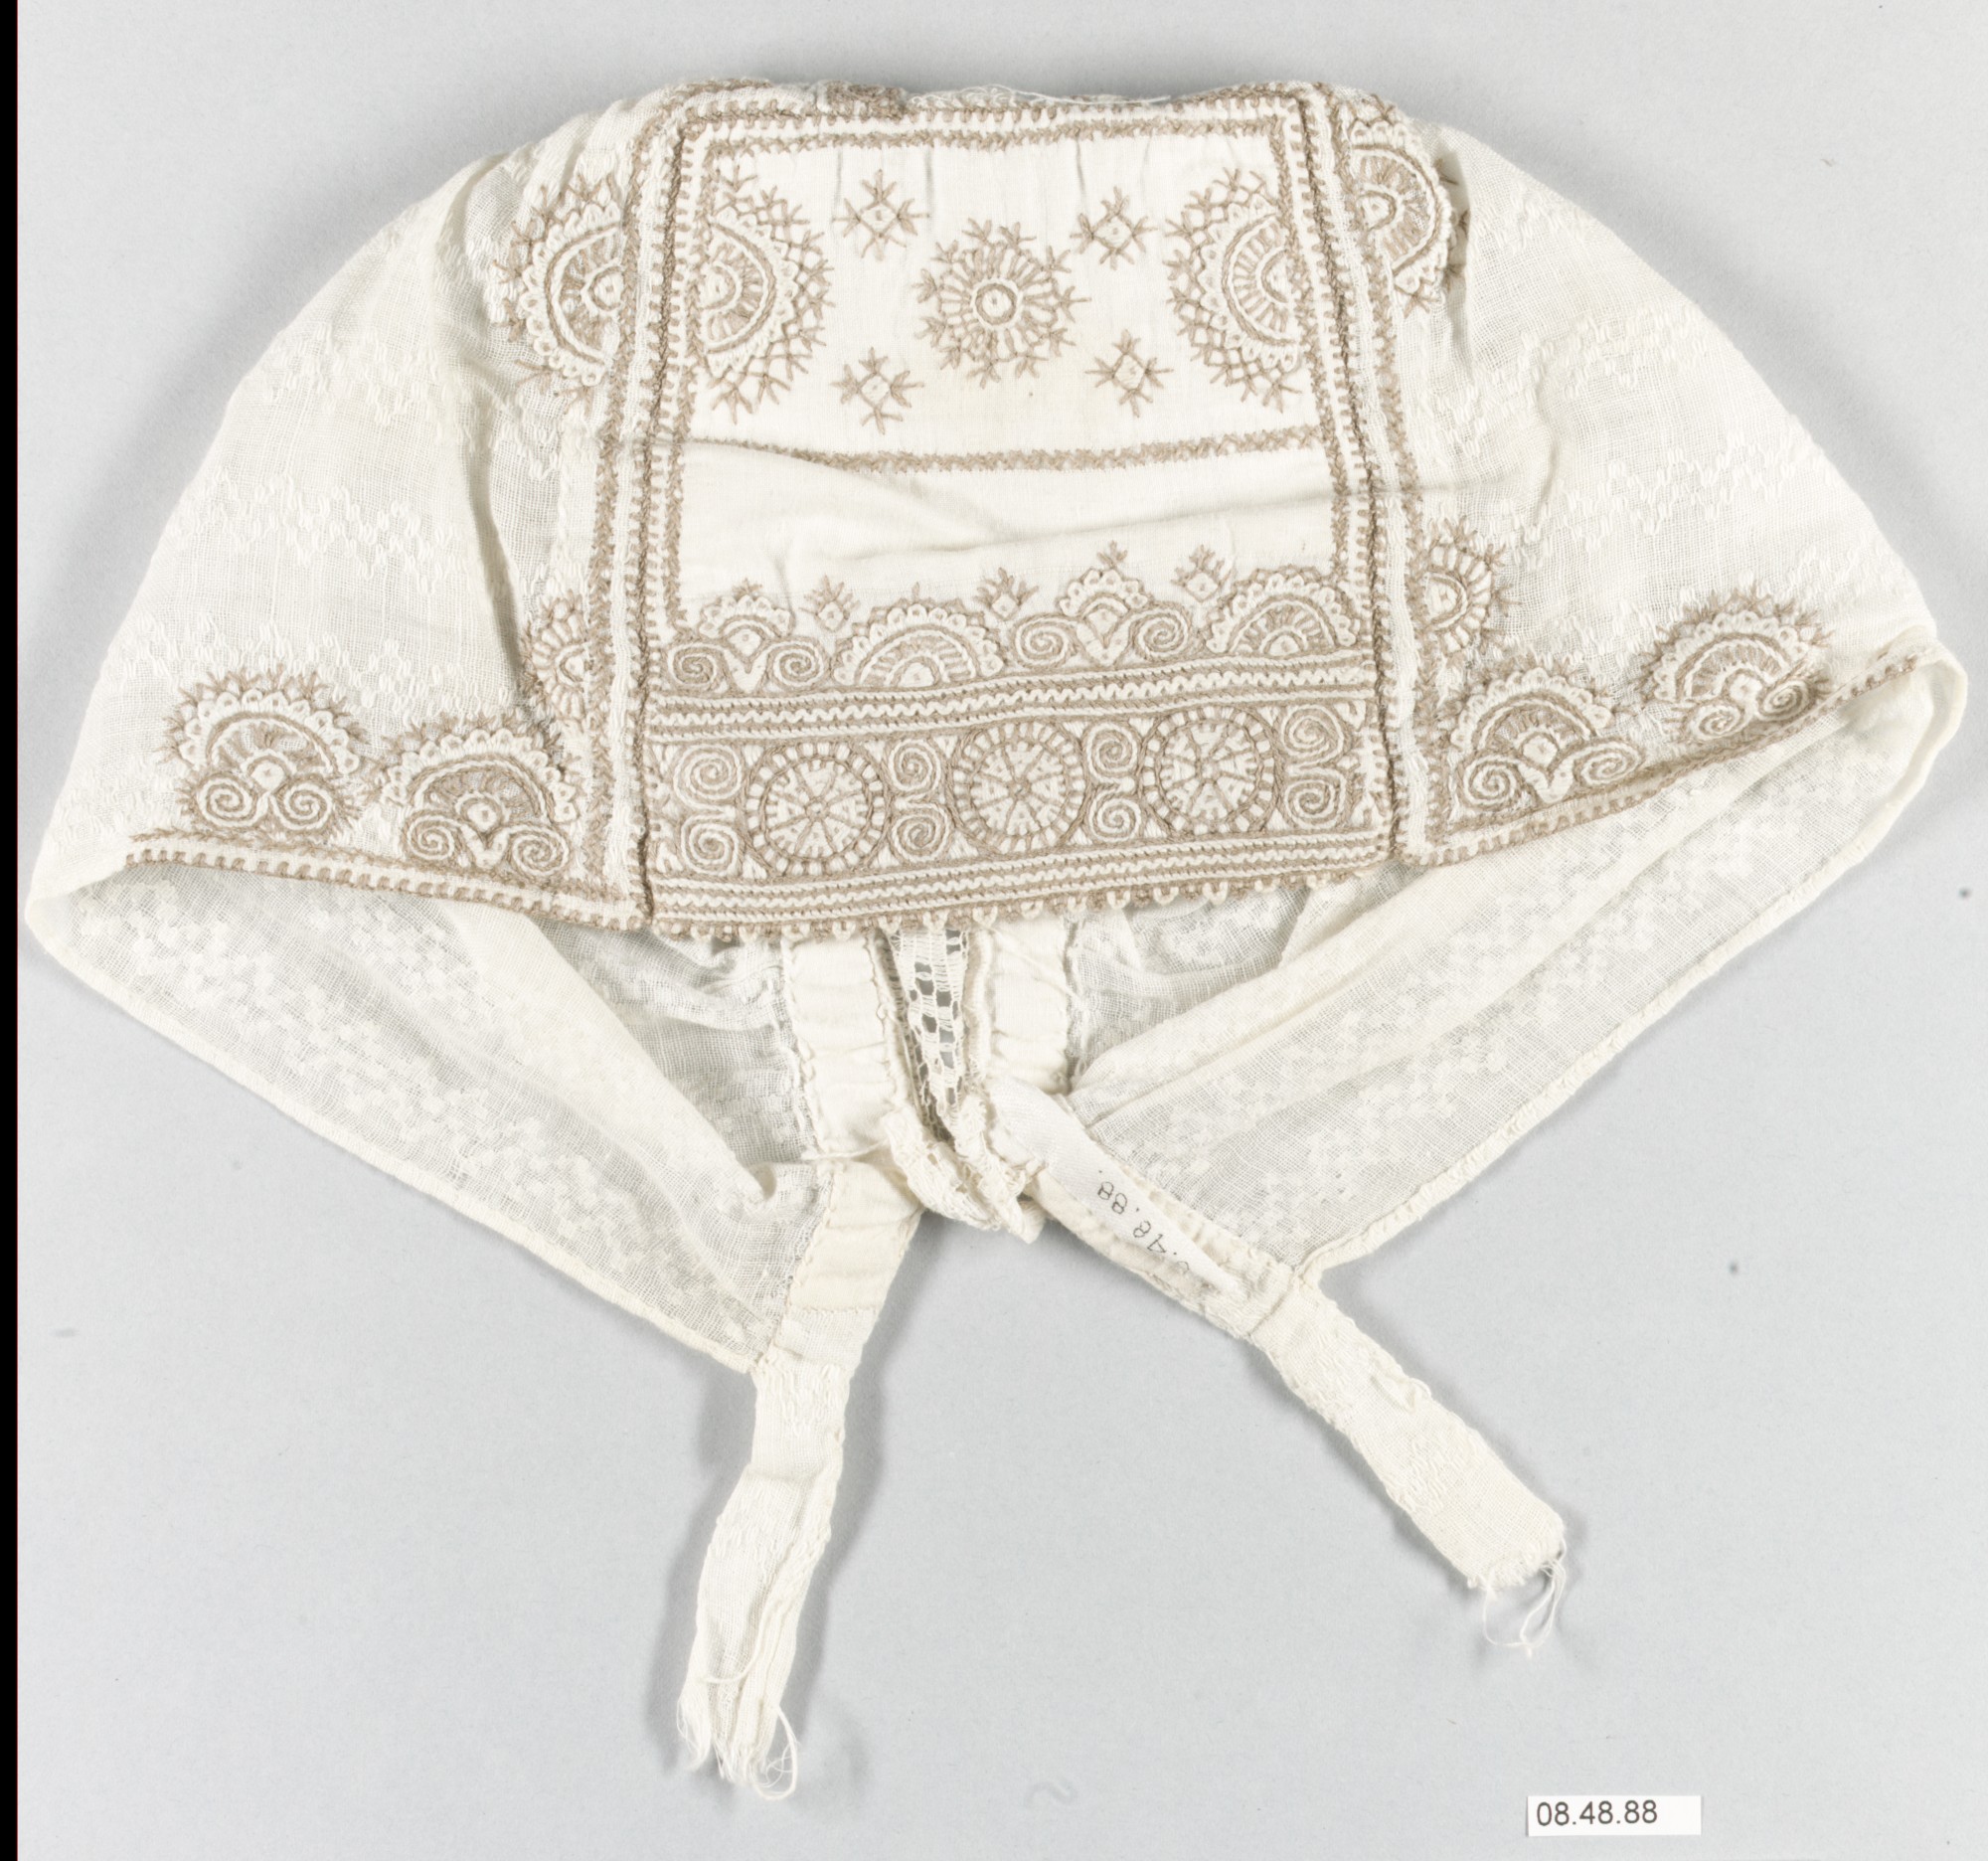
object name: cap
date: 1801-1900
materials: cotton